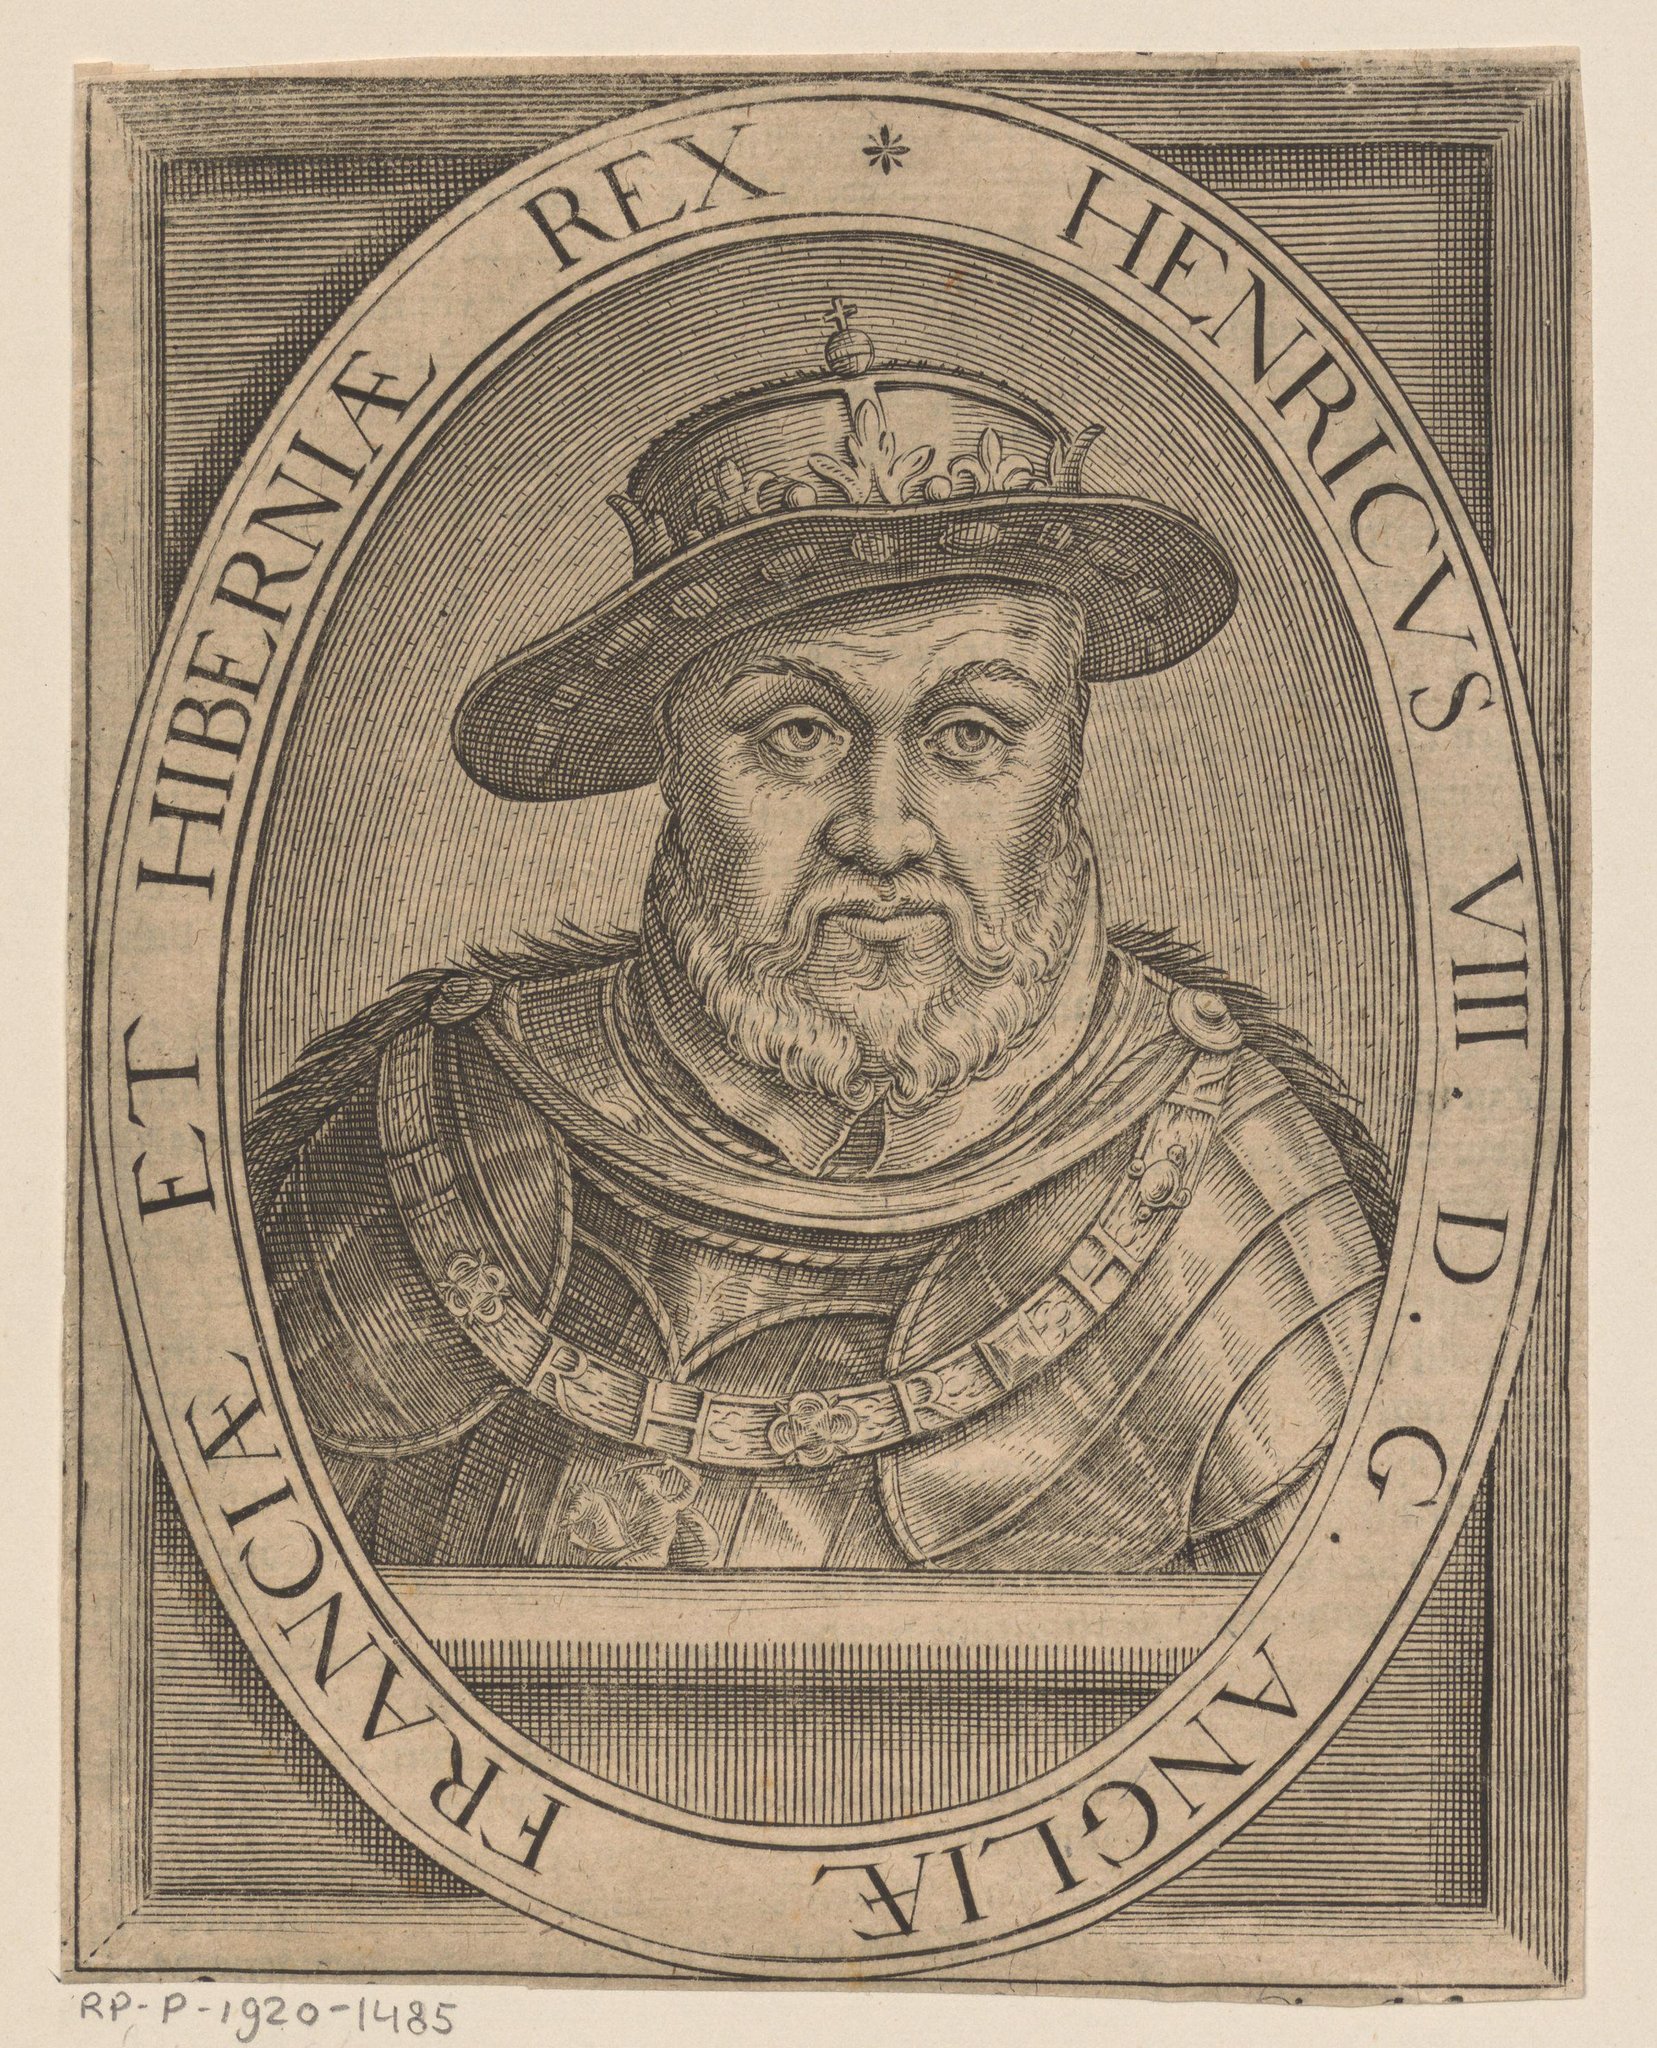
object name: print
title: Portret van Hendrik VIII, koning van Engeland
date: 1615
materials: paper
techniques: engraving, letterpress printing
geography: delft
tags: armour, historical persons, king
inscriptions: collector's mark: Lugt 2228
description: Prent uit: Clerck, Nicolaes de. Tooneel der keyseren en[de] coningen van christenryck sedert den onderganck van het Griecks keyserdom. Delft: Nicolaes de Clerck, 1615.